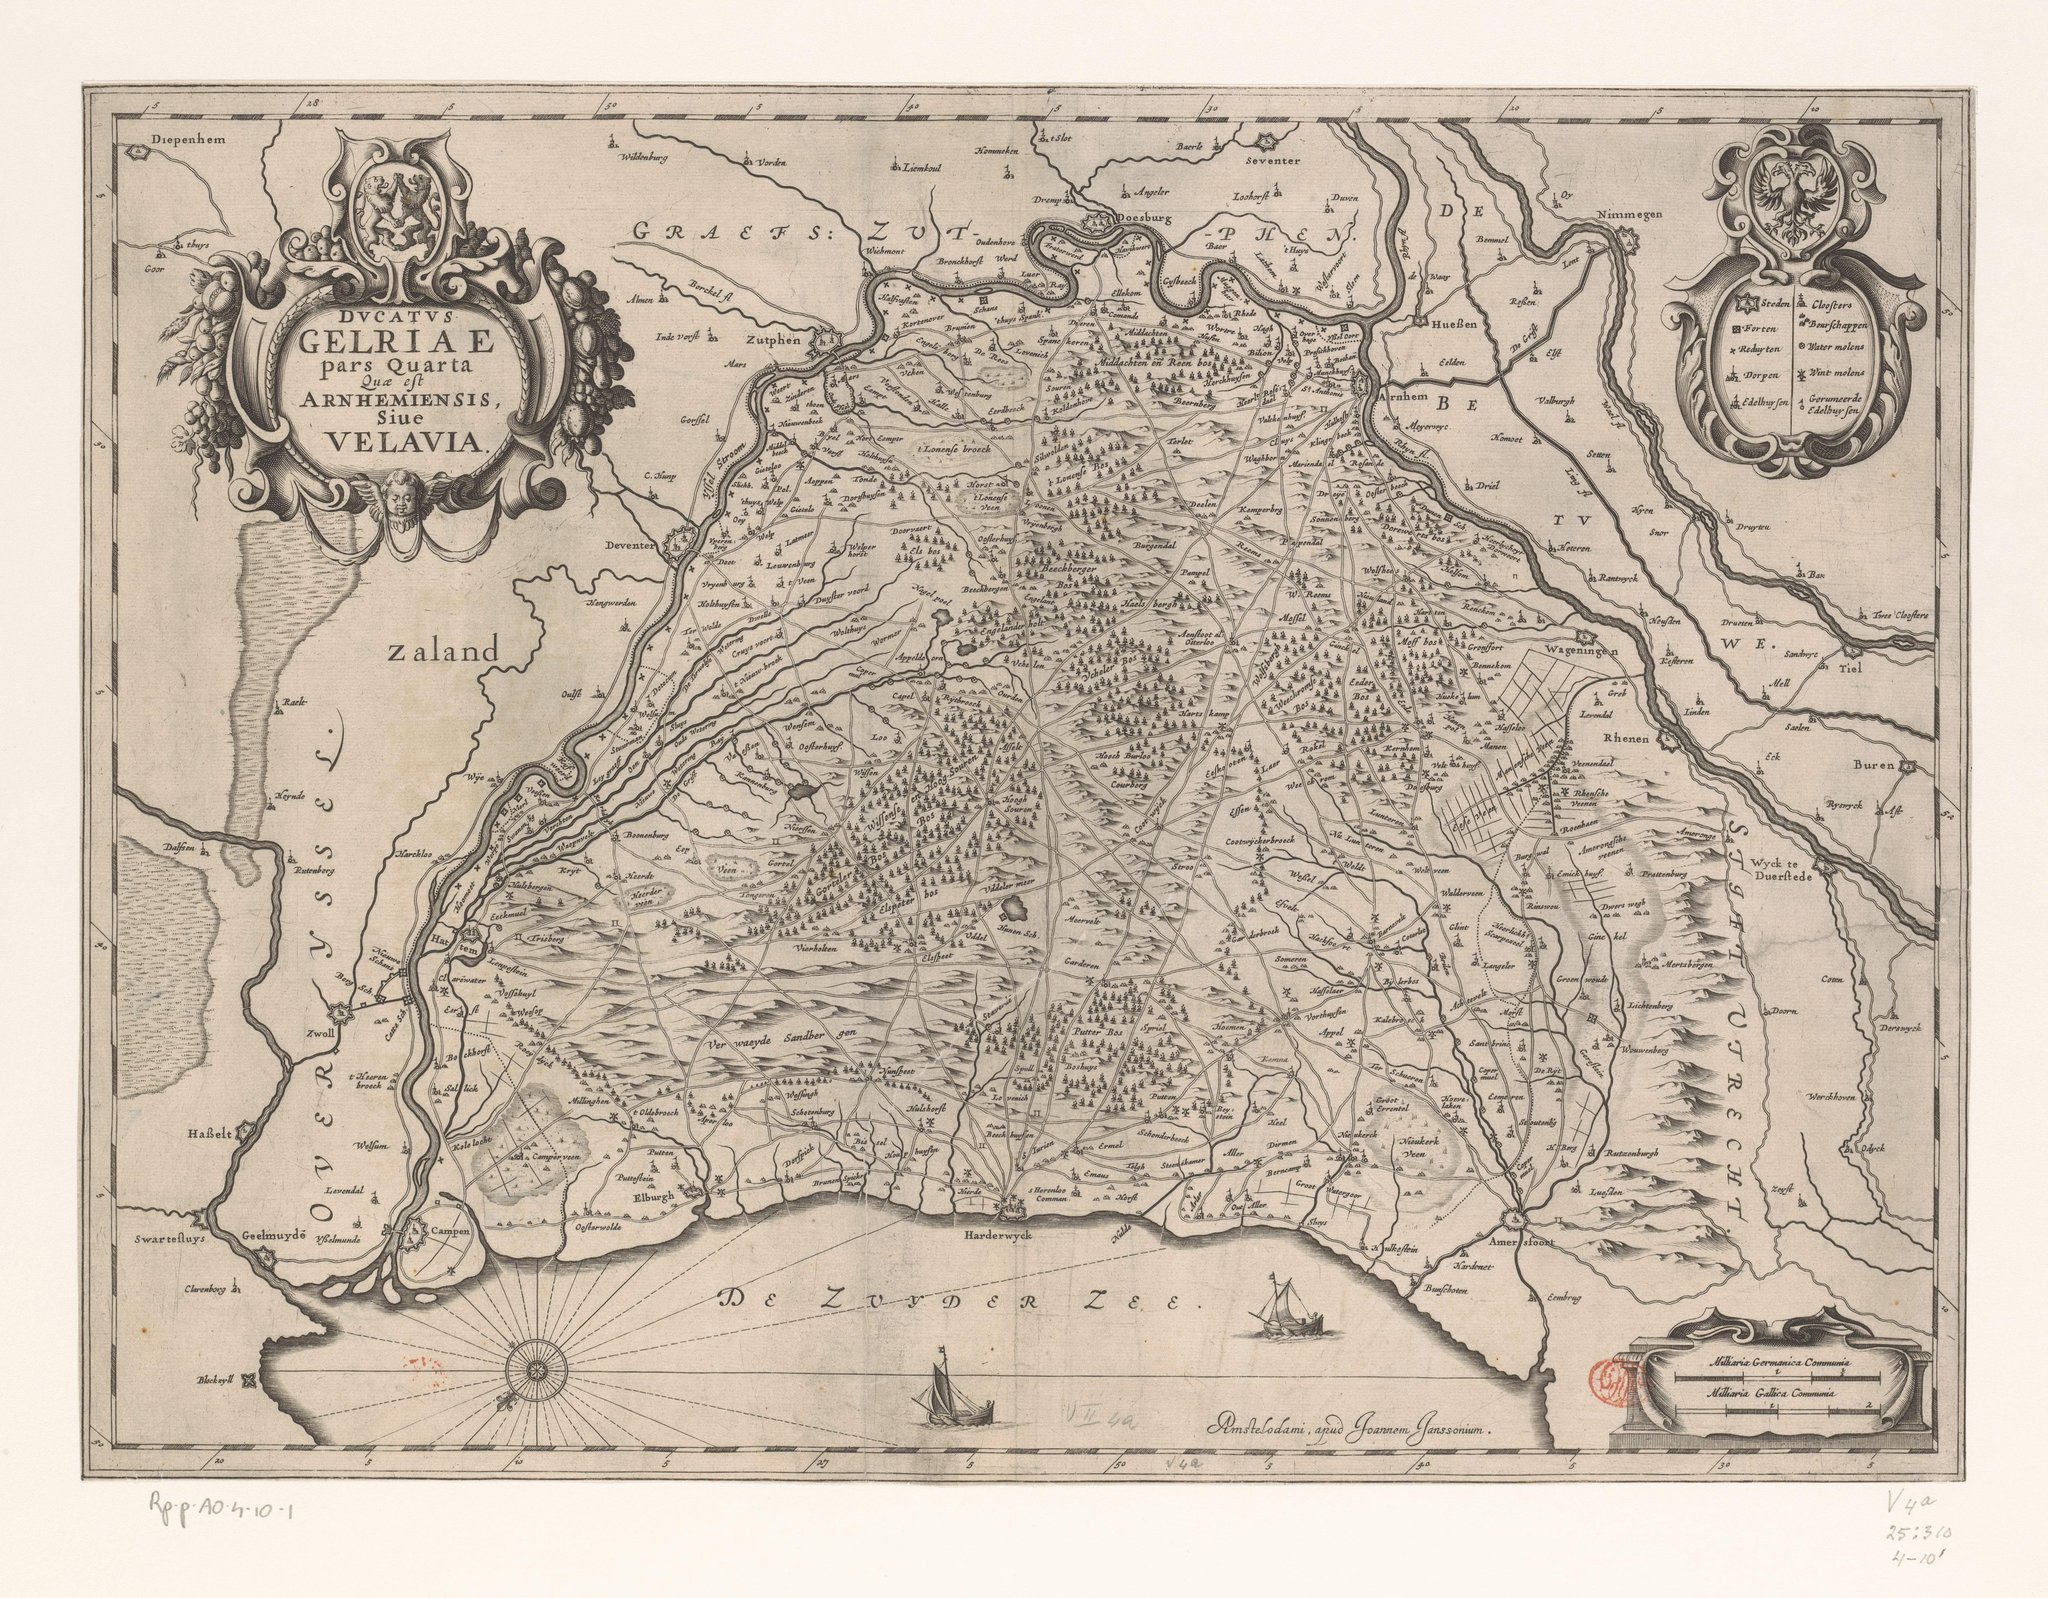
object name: print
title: Ducatus Gelriae pars quarta quae est Arnhemiensis, sive Velavia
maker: Anonymous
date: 1641-1680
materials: paper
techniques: engraving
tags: maps of separate countries or regions, coat of arms (as symbol of the state, etc.) (+ province; provincial)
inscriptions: collector's mark: Lugt 195, collector's mark: Lugt 2228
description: Linksboven de titelcartouche, met bovenin het wapen van Gelre. Rechtsboven een cartouche met legenda, bovenin het wapen van het kwartier van Arnhem. Rechtsonder een cartouche met twee schaalstokken: 1 1/2 Milliaria Germanica Communia / 2 Milliaria Gallica Communia. De kaart is voorzien van een gradenverdeling langs de randen.